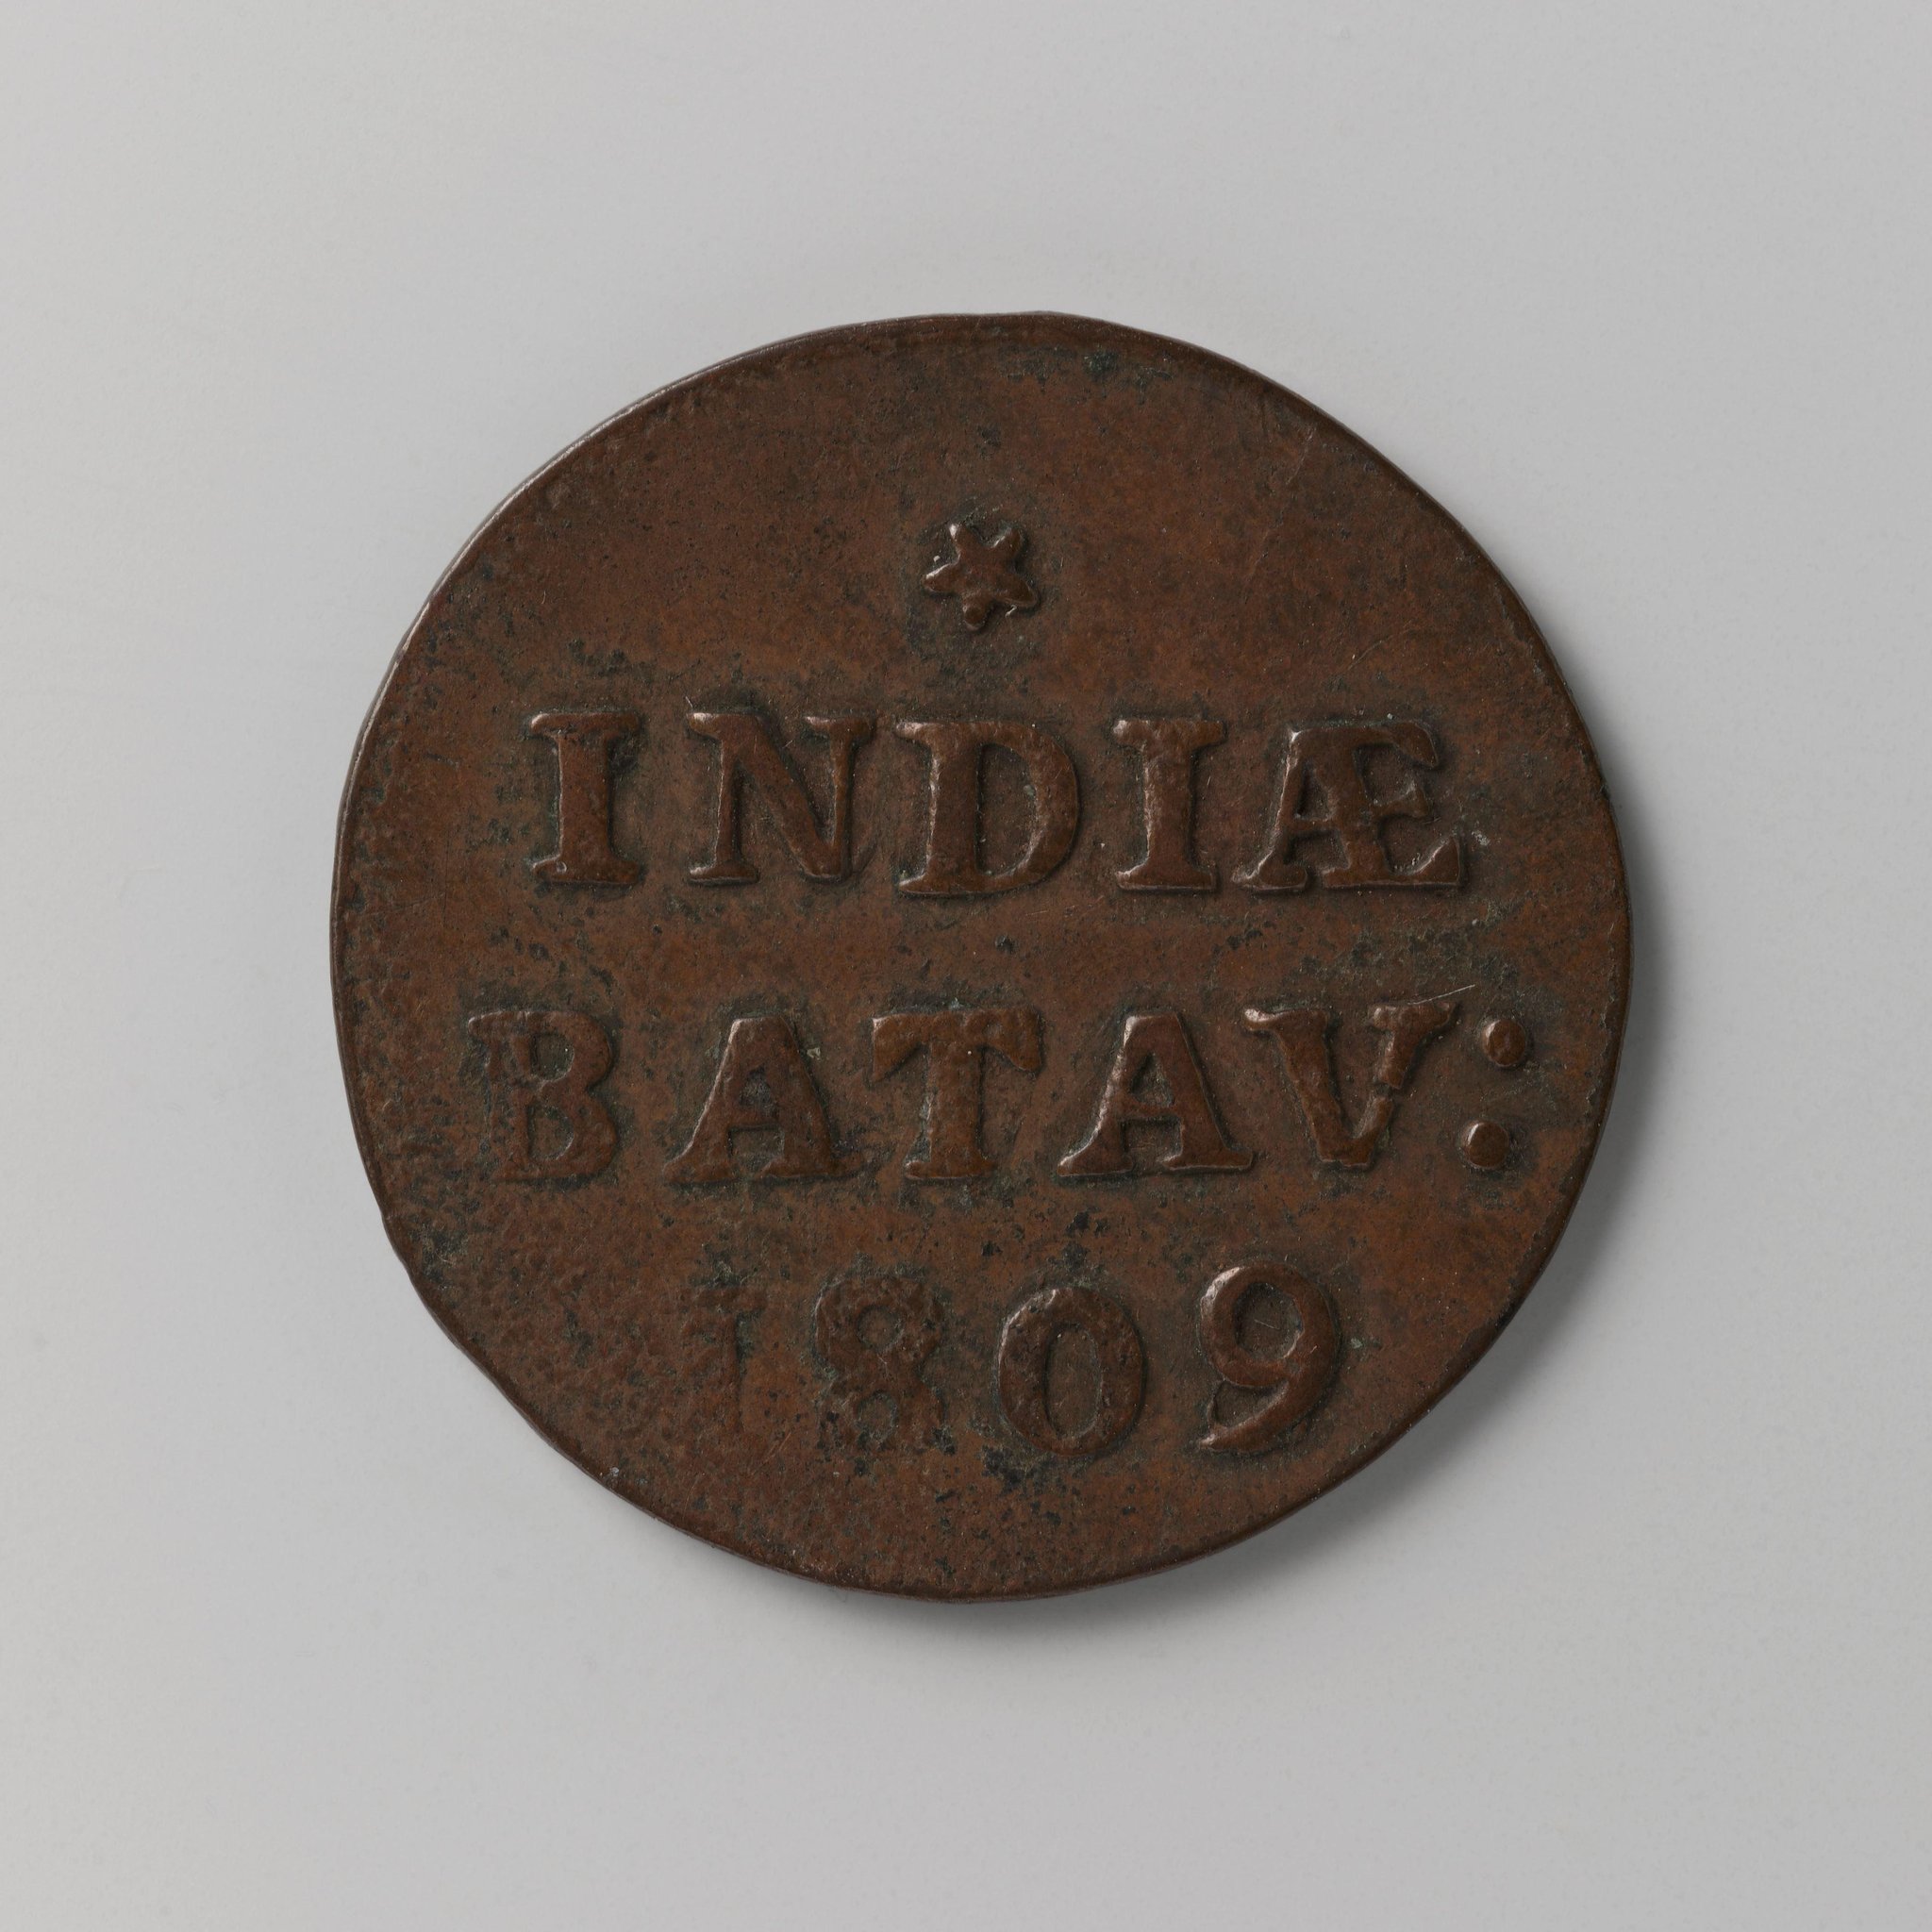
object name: coin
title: Duit voor Nederlands Indië uit Holland,1809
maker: louis napoleon (king of holland)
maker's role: koning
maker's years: 1778-1846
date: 1809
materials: copper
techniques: striking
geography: hoorn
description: Koperen munt. Voorzijde: tweeregelig opschrift, waarboven muntteken ster en waaronder jaartal. Keerzijde: tussen waarde-aanduiding 5 1/16 G gekroond generaliteitswapenschild. Gladde rand.